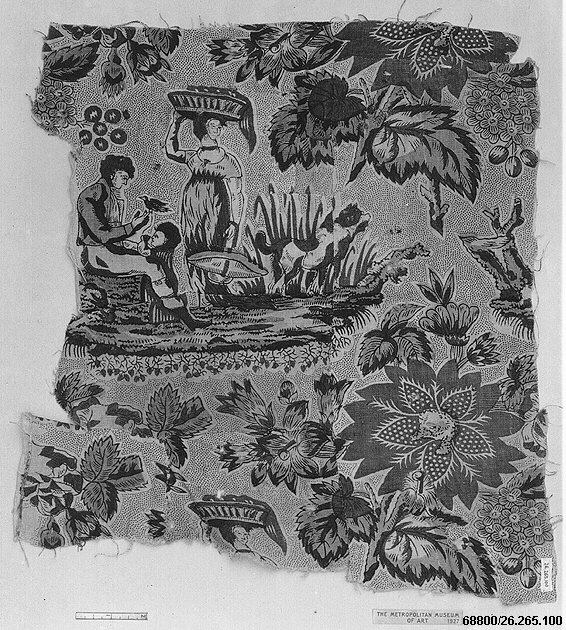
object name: piece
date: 1800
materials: cotton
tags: men,women,flowers,leaves